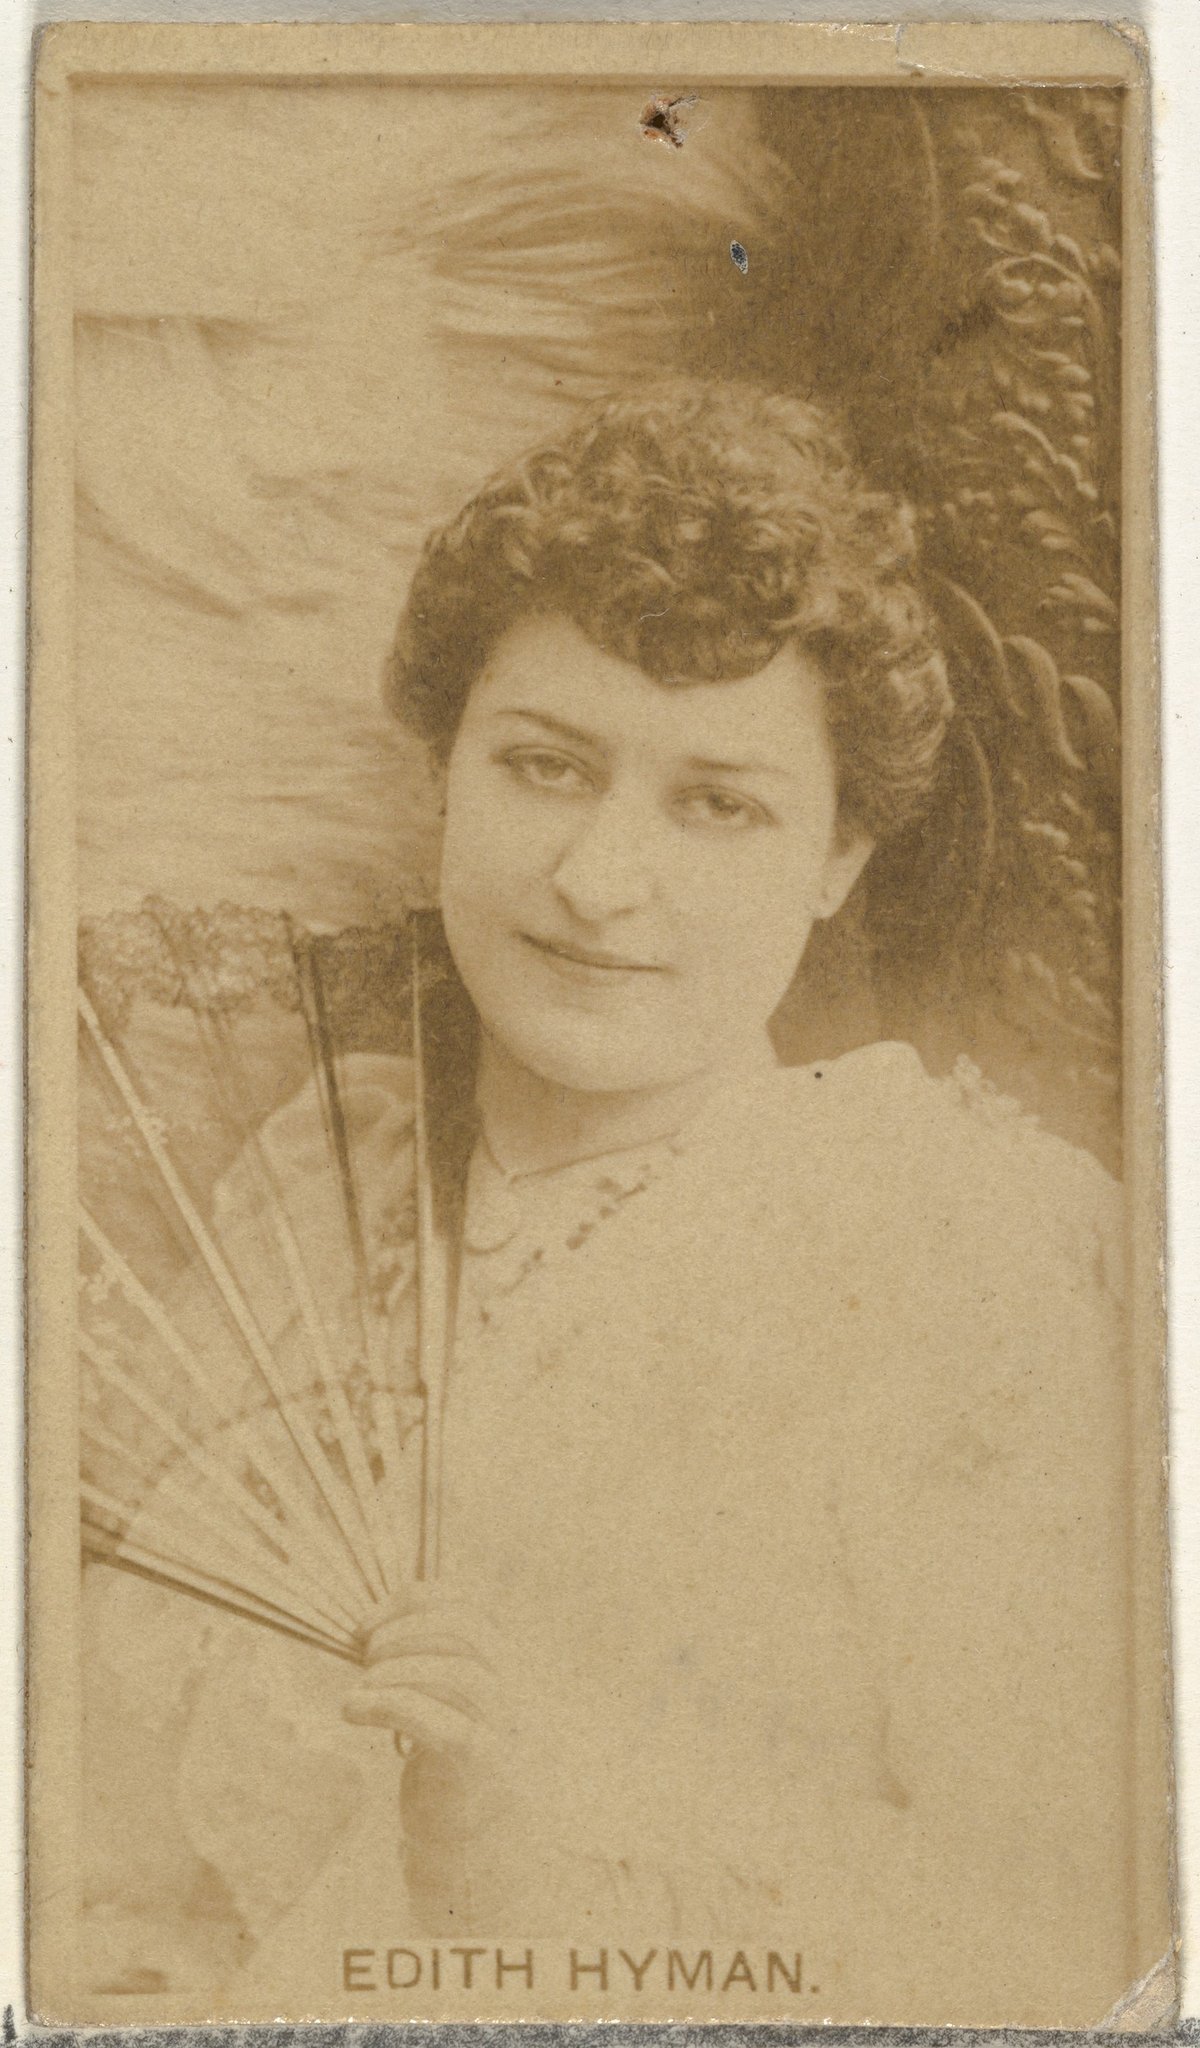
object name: photograph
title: Edith Hyman, from the Actors and Actresses series (N145-8) issued by Duke Sons & Co. to promote Duke Cigarettes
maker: w. duke, sons & co.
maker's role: publisher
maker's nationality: american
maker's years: 1870-1920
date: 1891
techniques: albumen silver print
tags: portraits,women,actresses